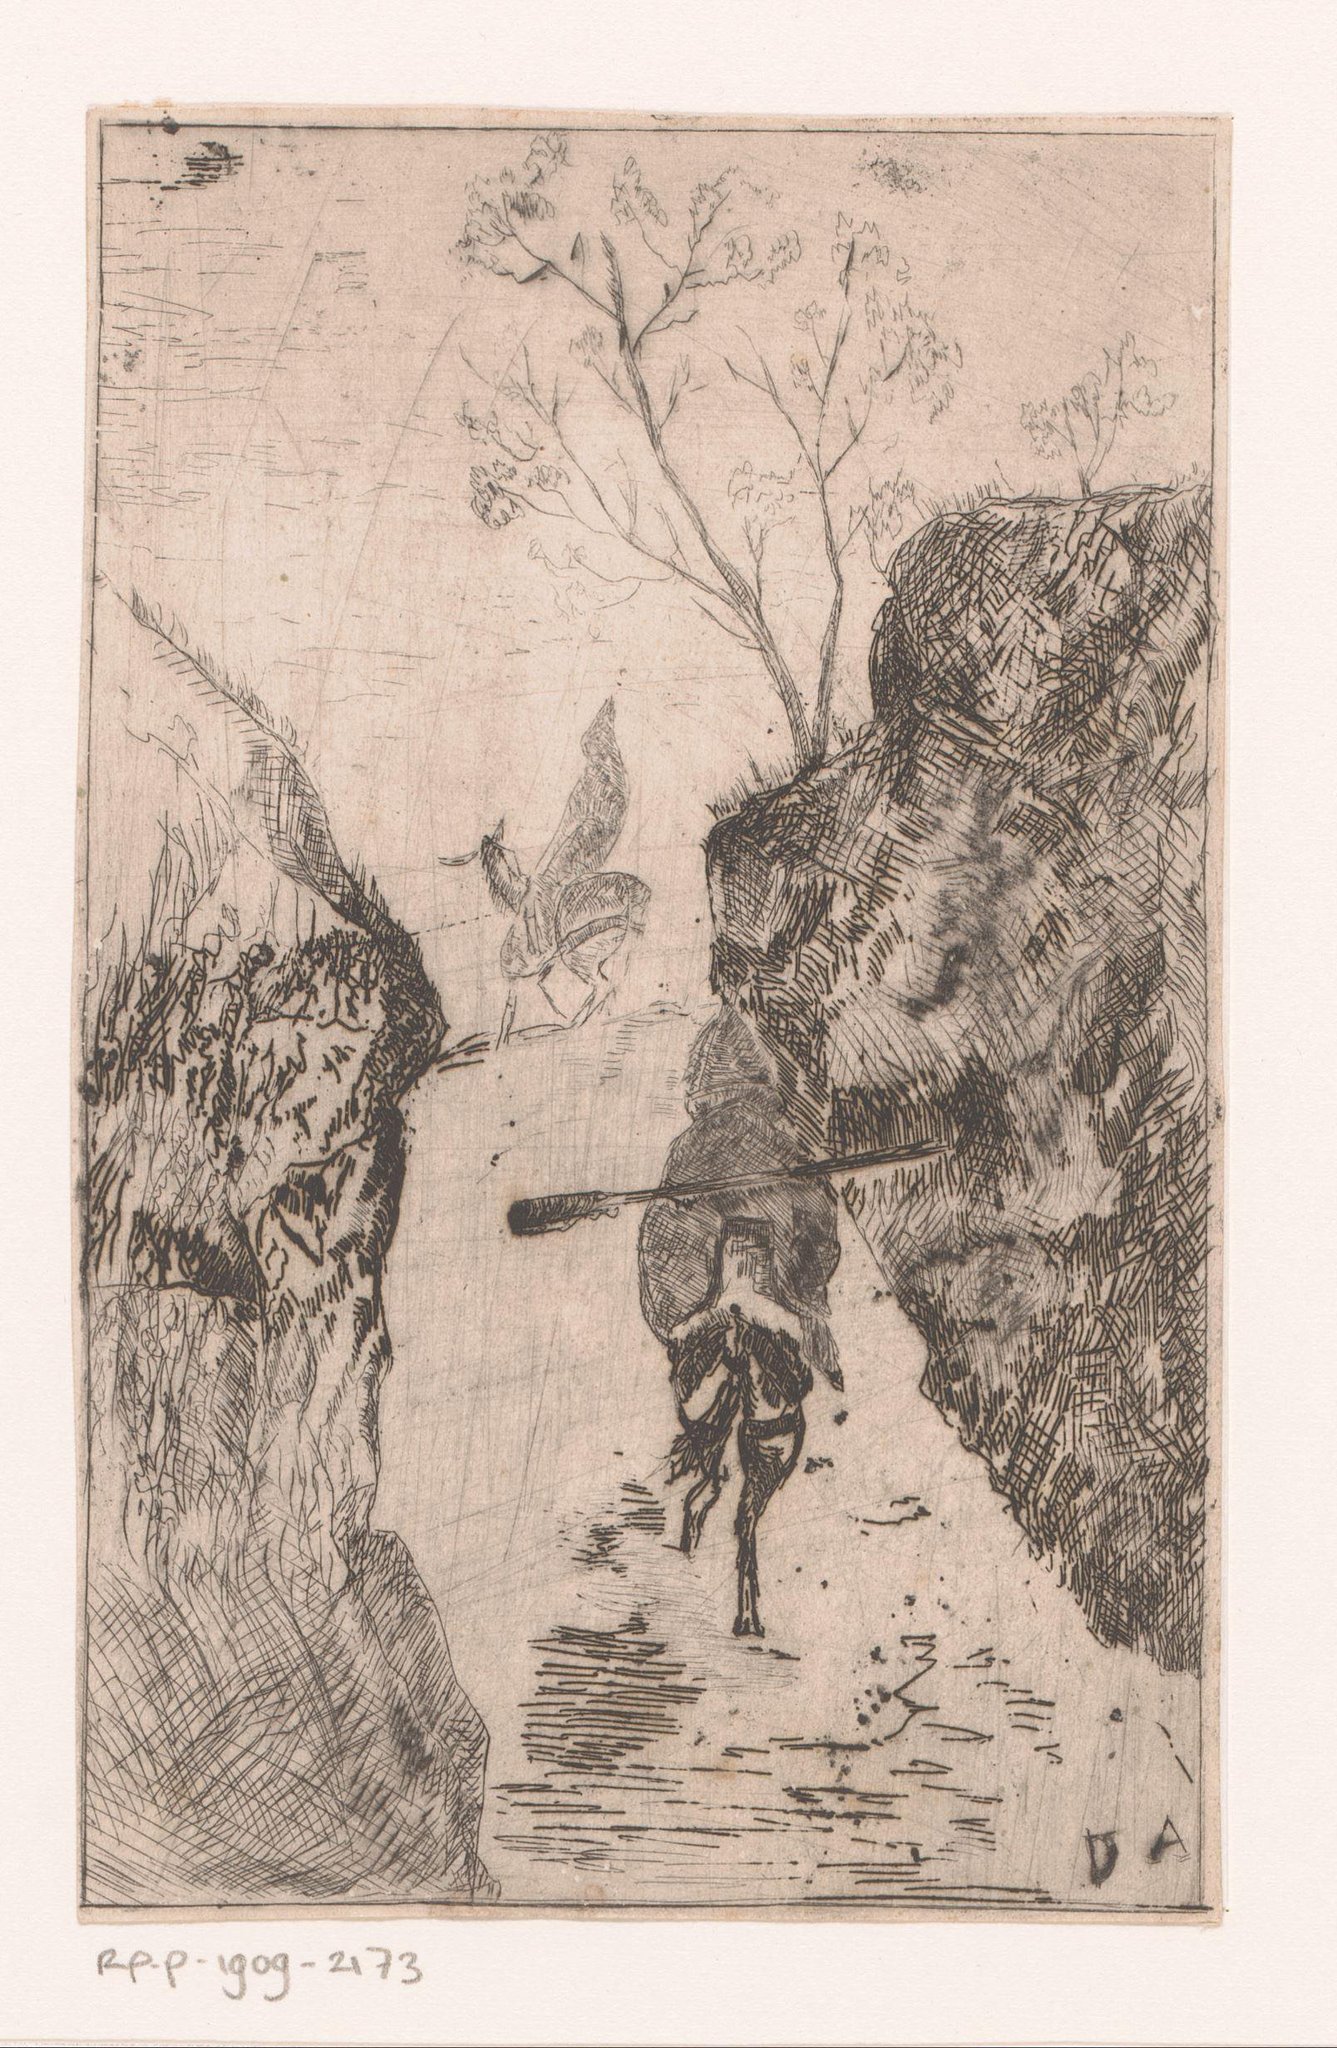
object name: print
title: Twee ruiters op een bergweg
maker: vicomte arthur-jean le bailly dinghuem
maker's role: print maker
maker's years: 1839-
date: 1875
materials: paper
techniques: drypoint, etching, intaglio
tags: riding a horse, ass, or mule; rider, horseman, rocks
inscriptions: collector's mark: Lugt 2228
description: Onderdeel van een serie van twaalf prenten. Prent gedrukt op een versneden blad met op verso in litho de benen van Junon Somnifère.